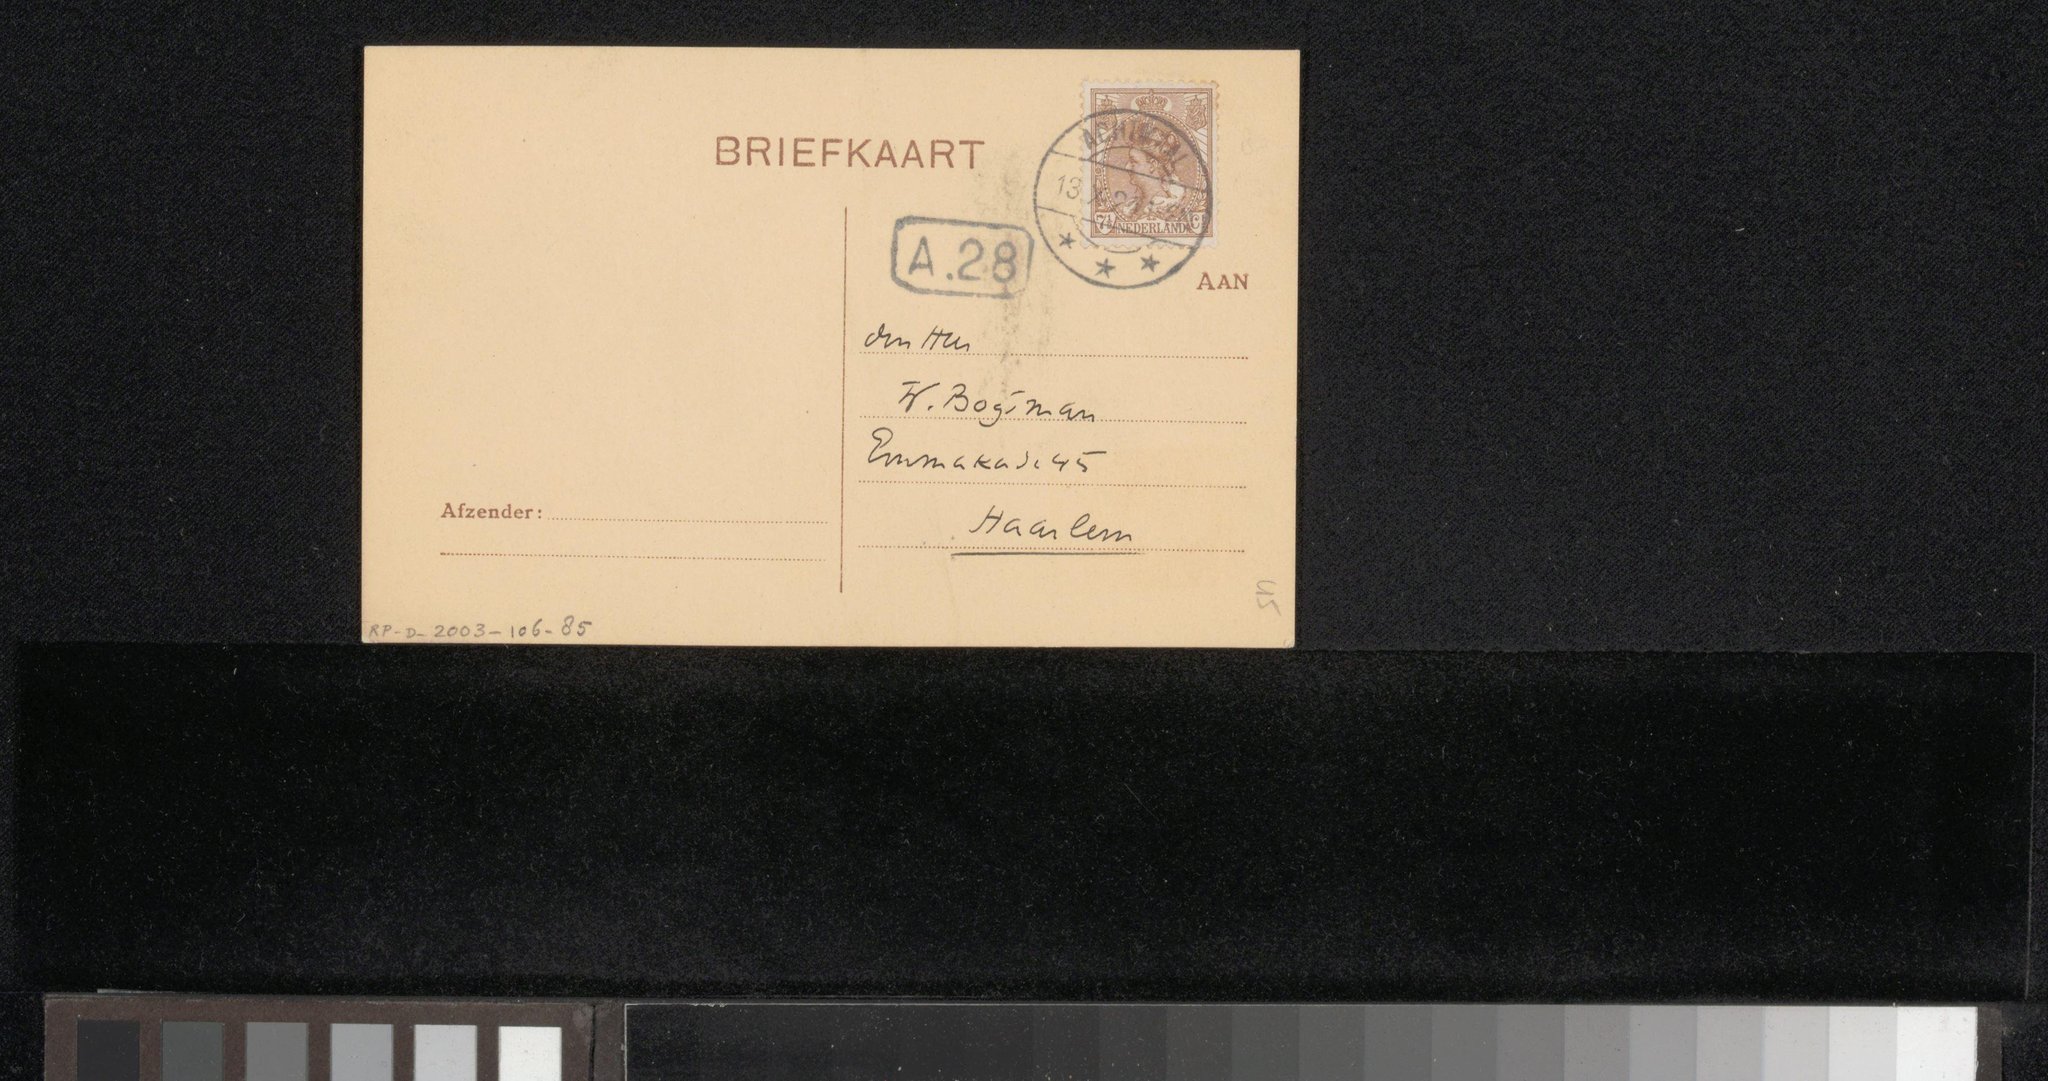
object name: postcard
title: Briefkaart aan Willem Bogtman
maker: richard nicolaüs roland holst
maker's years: 1868-1938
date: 1924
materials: cardboard, ink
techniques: pen, writing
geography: achtmaal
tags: willem bogtman